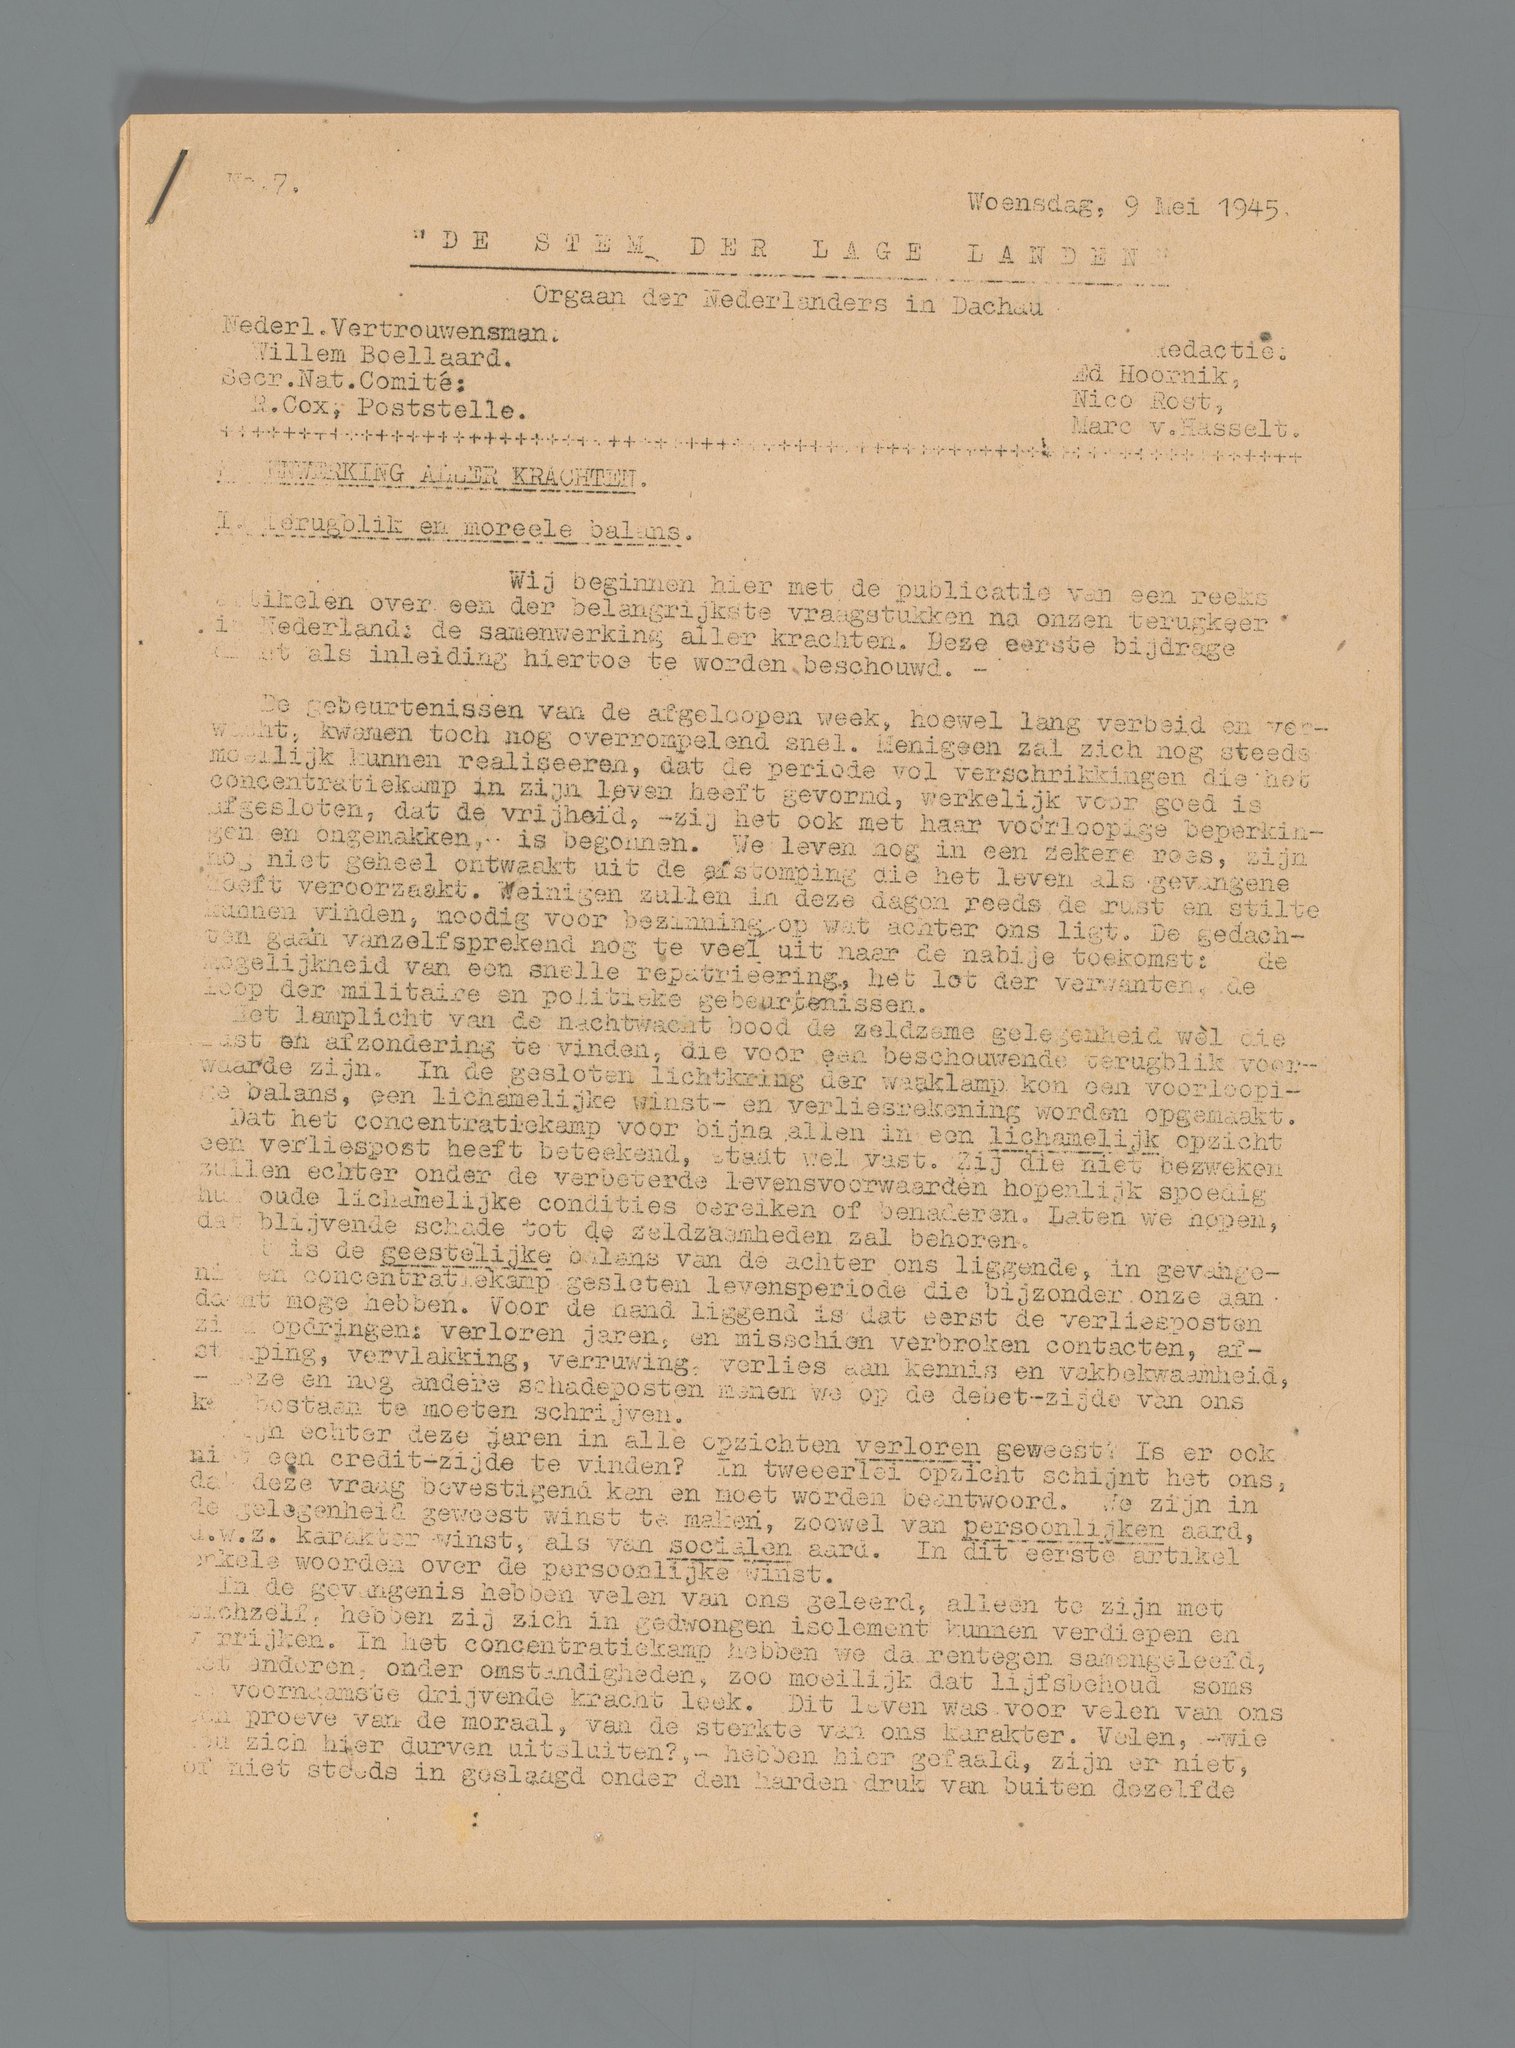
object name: newspaper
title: De stem der lage landen, nr. 7, 9 mei 1945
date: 1945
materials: paper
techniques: mimeography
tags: rotterdam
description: Gestencilde krant 'De stem der lage landen / Orgaan der Nederlanders in Dachau', aflevering nr. 7, 9 mei 1945. Drie bladen bedrukt aan beide zijden. Verschenen onder redactie van Ed Hoornik, Nico Rost en Marc van Hasselt.